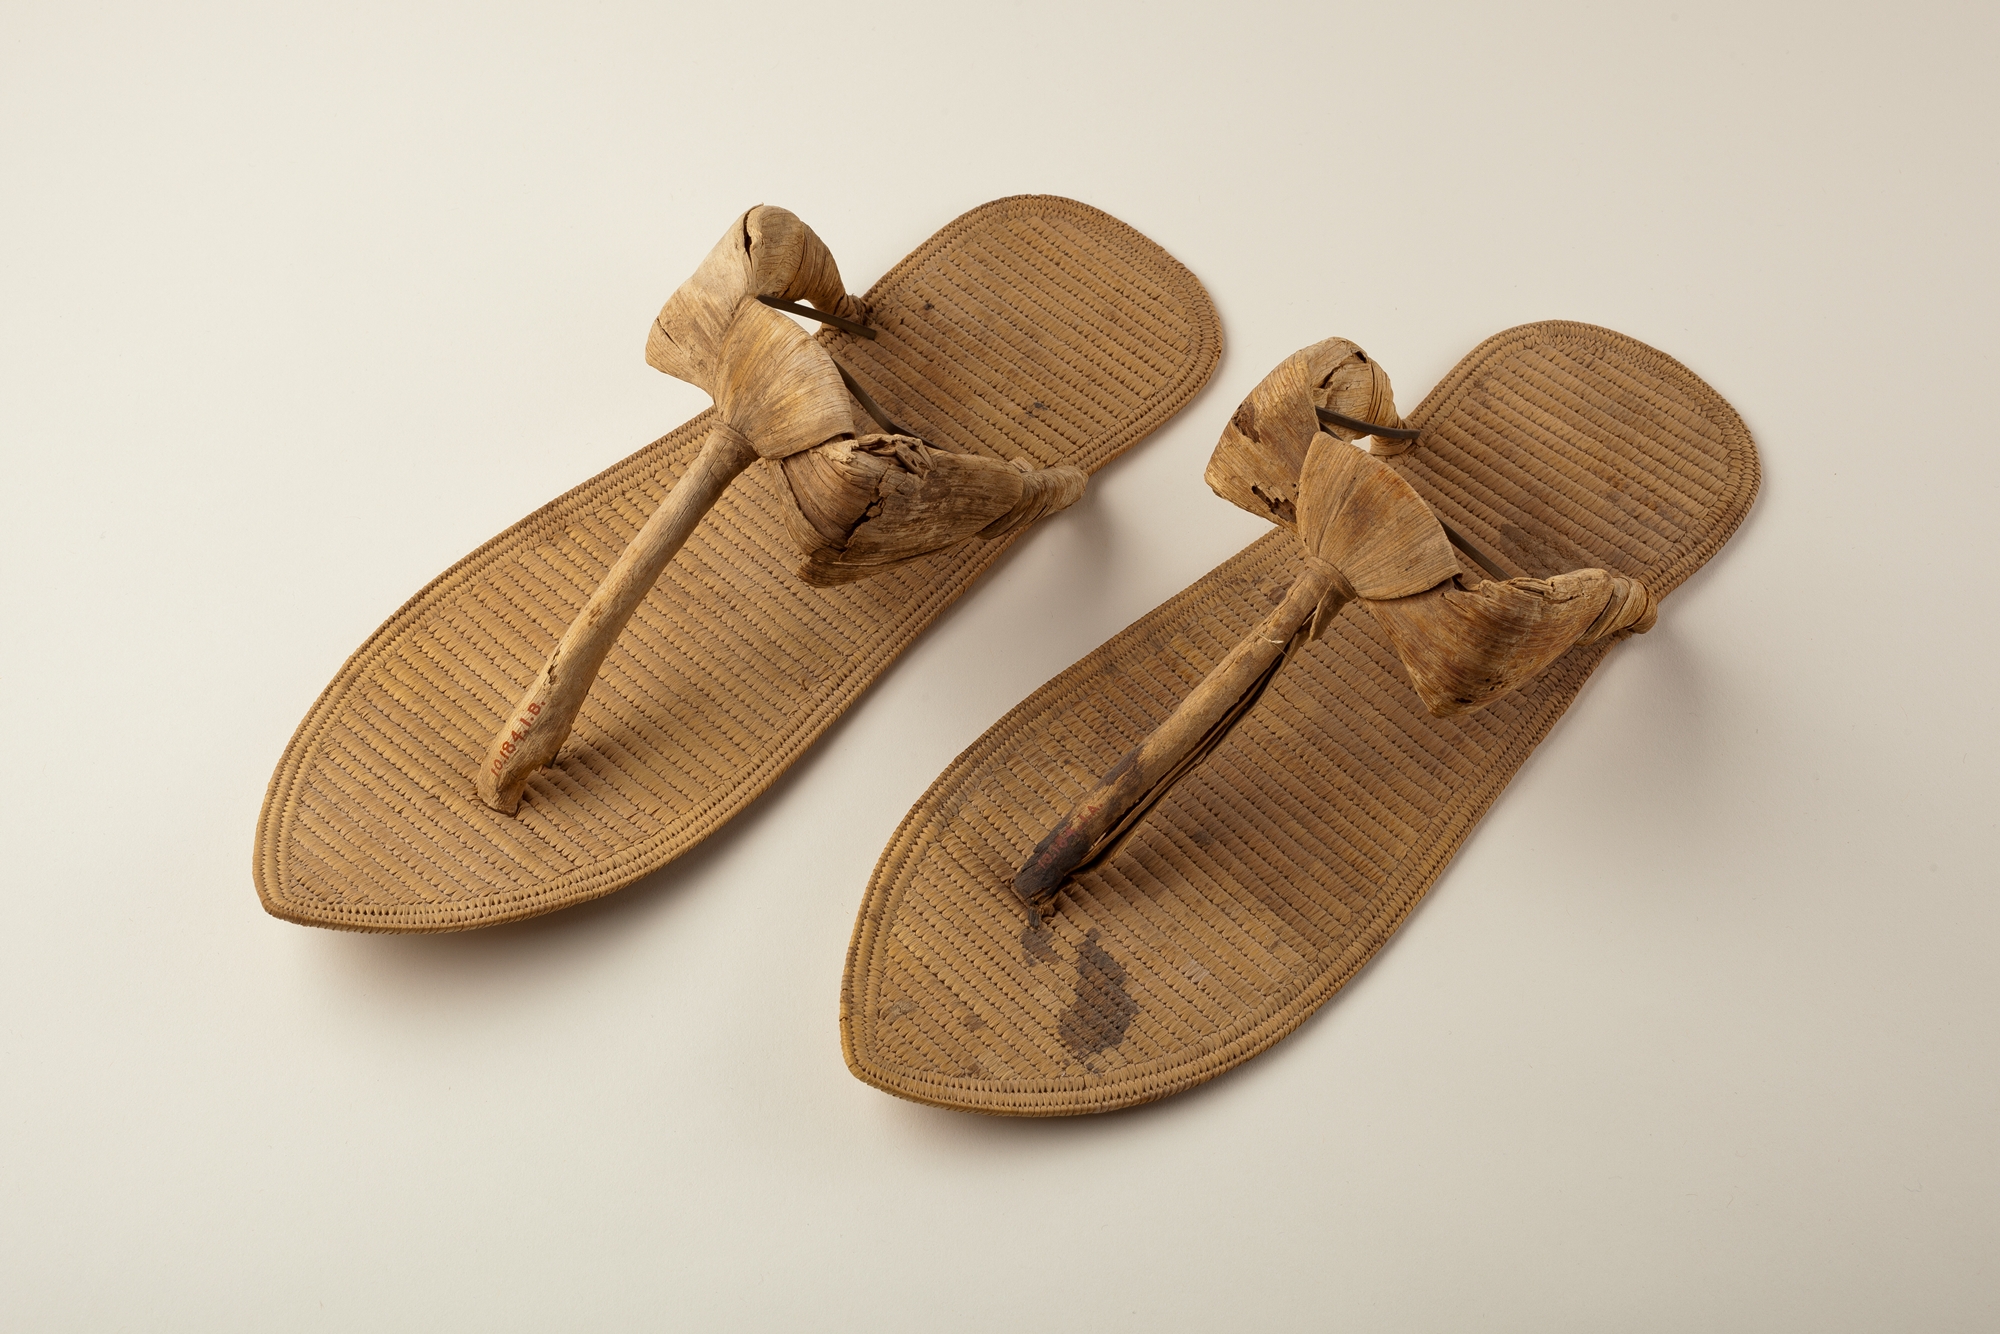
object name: sandal, yuya tjuyu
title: Pair of Sandals from the Tomb of Yuya and Tjuyu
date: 1390-1352 BCE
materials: papyrus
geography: egypt